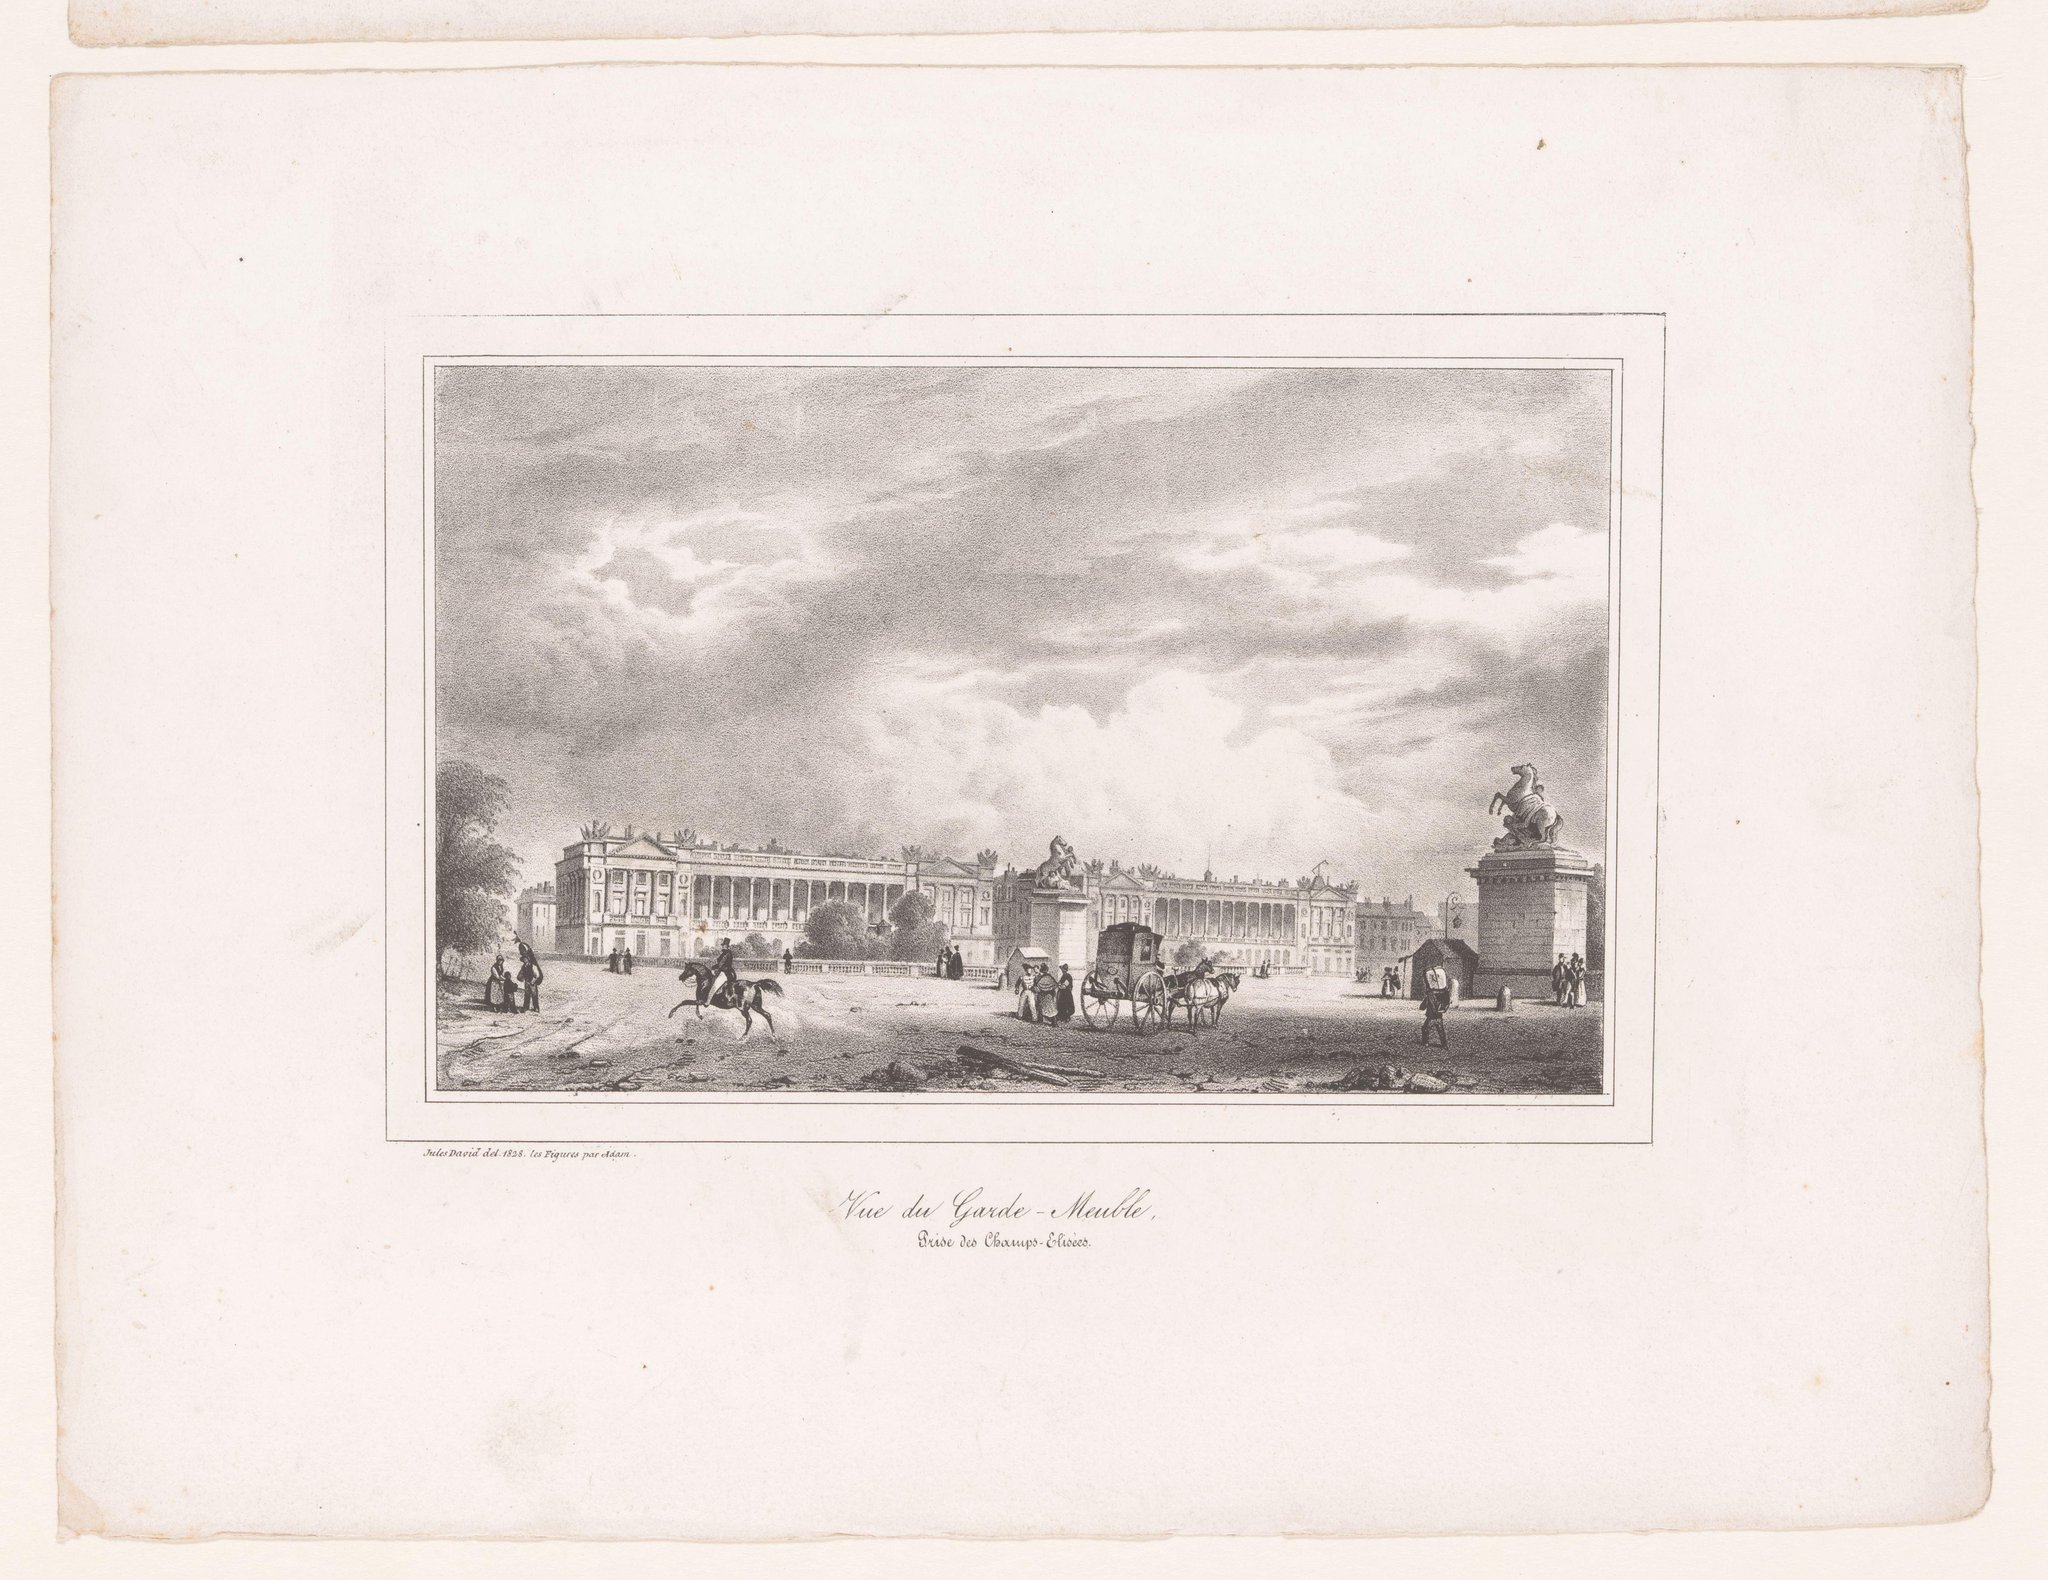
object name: print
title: Gezicht op het Hôtel du Garde-Meuble vanaf de Champs-Élysées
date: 1828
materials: paper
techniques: lithograph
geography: paris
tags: hôtel, i.e. small palace in city, paris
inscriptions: collector's mark: Lugt 2228